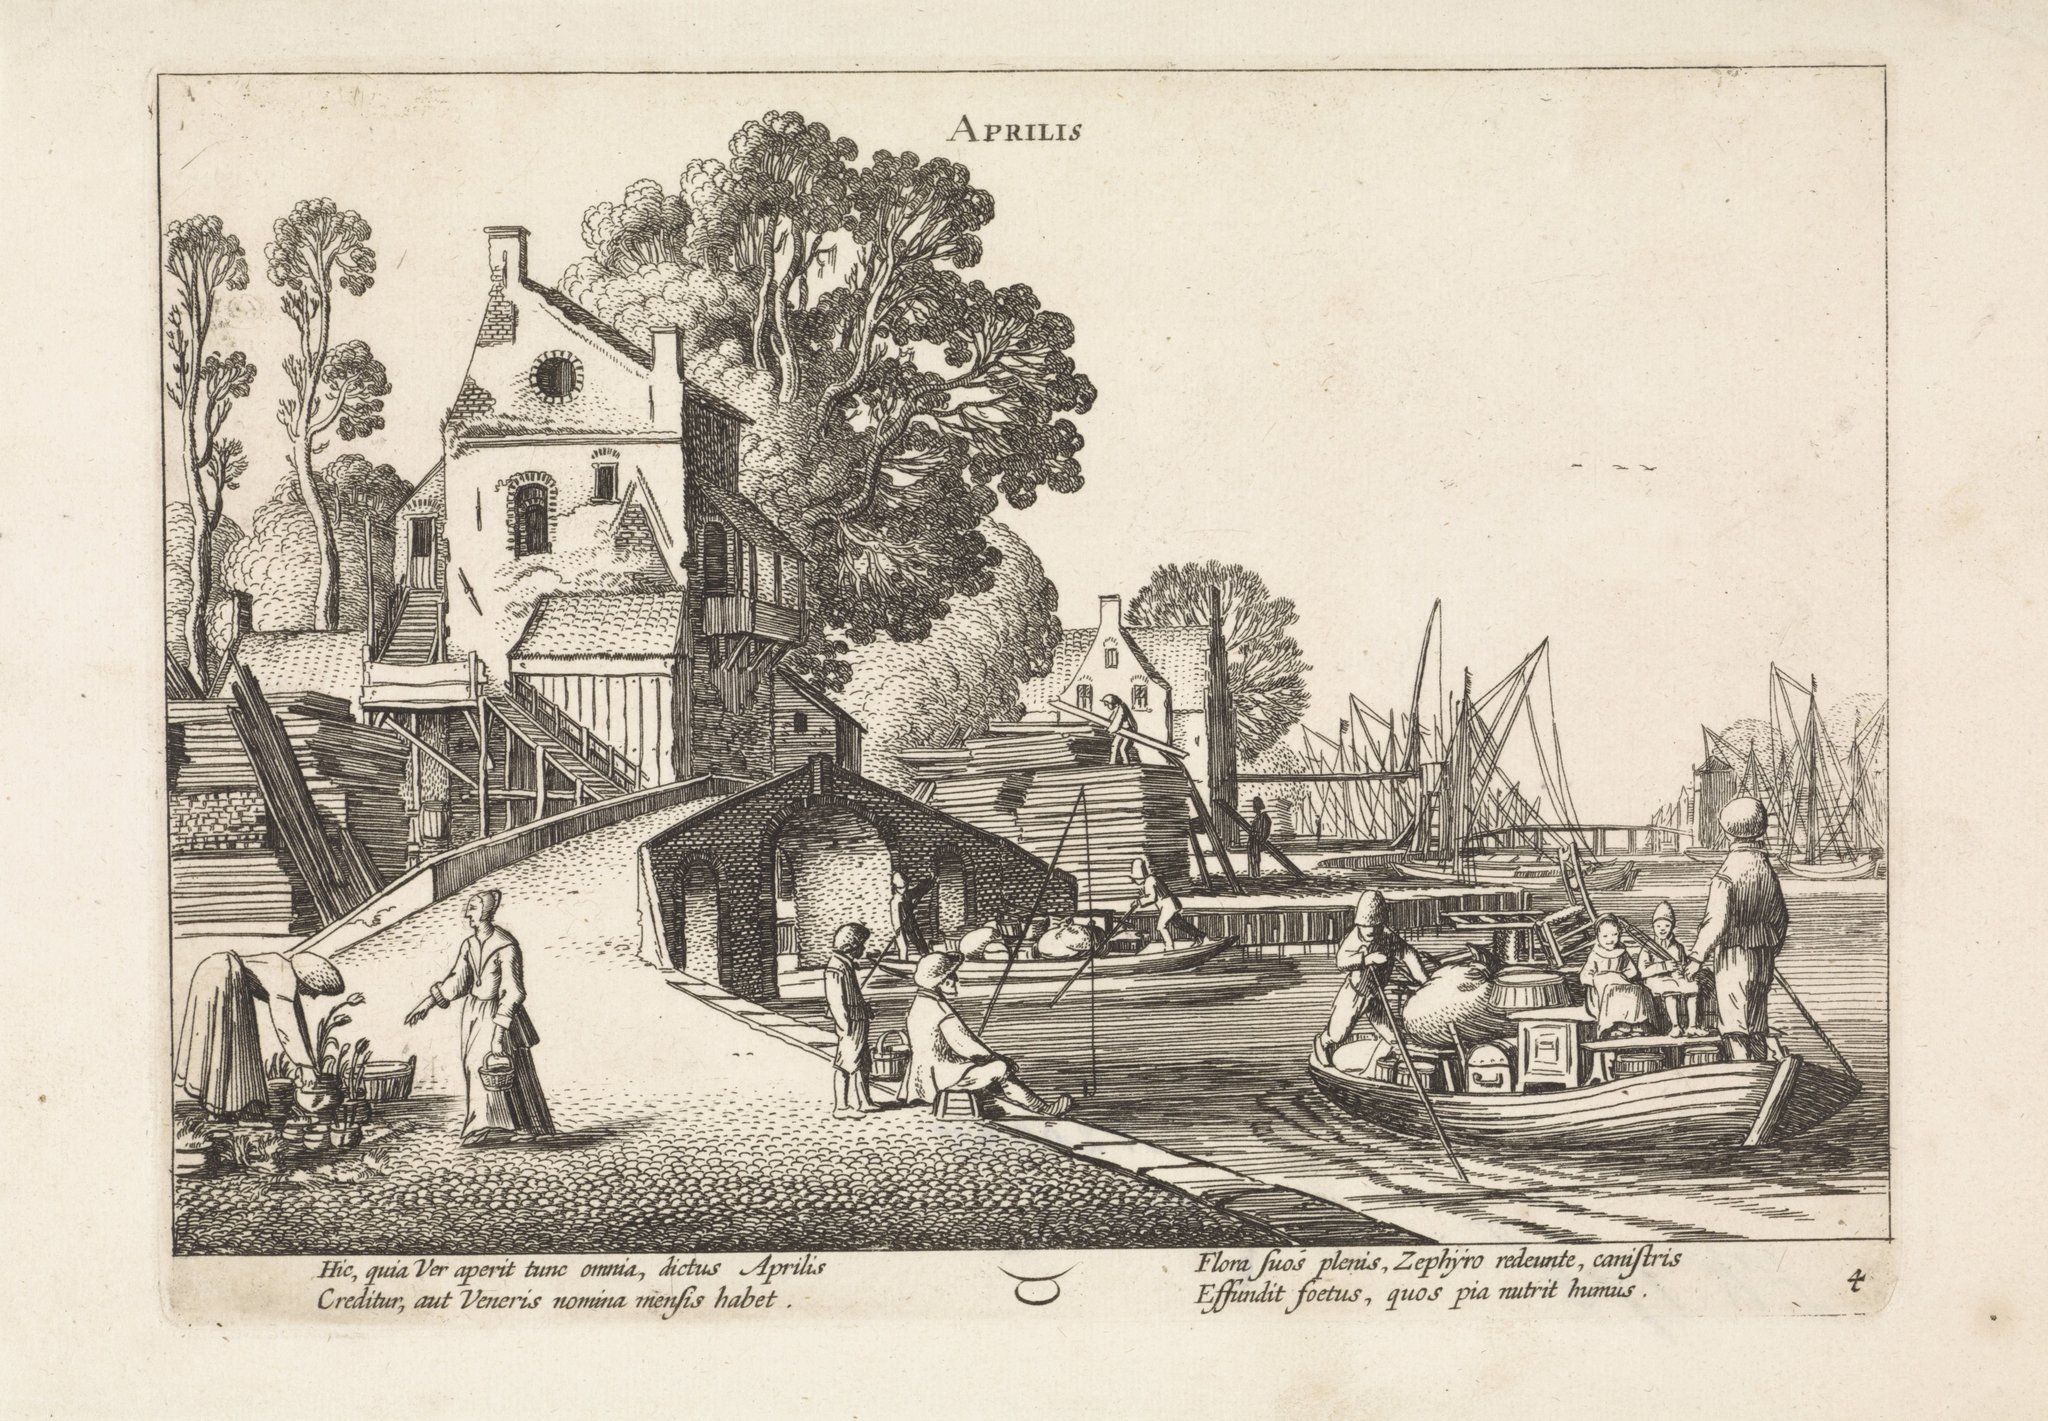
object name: print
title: Duodecim anni mensium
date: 1608-1618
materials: paper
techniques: etching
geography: northern netherlands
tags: landscape symbolizing april, taurus (zodiacal sign of april), traffic on the water, angling, bridge in village across river, canal, etc.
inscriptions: collector's mark: Lugt 964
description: Gezicht op een dorp met een stenen brug, waar op de kade en op het water veel bedrijvigheid is, voorstellende de maand april. Links een vrouw bij een bloemenverkoper, op de kade een visser en op het water een roeiboot met een echtpaar en veel huisraad. Onderaan het astrologische symbool van het sterrenbeeld stier. Prent uit een serie van twaalf.